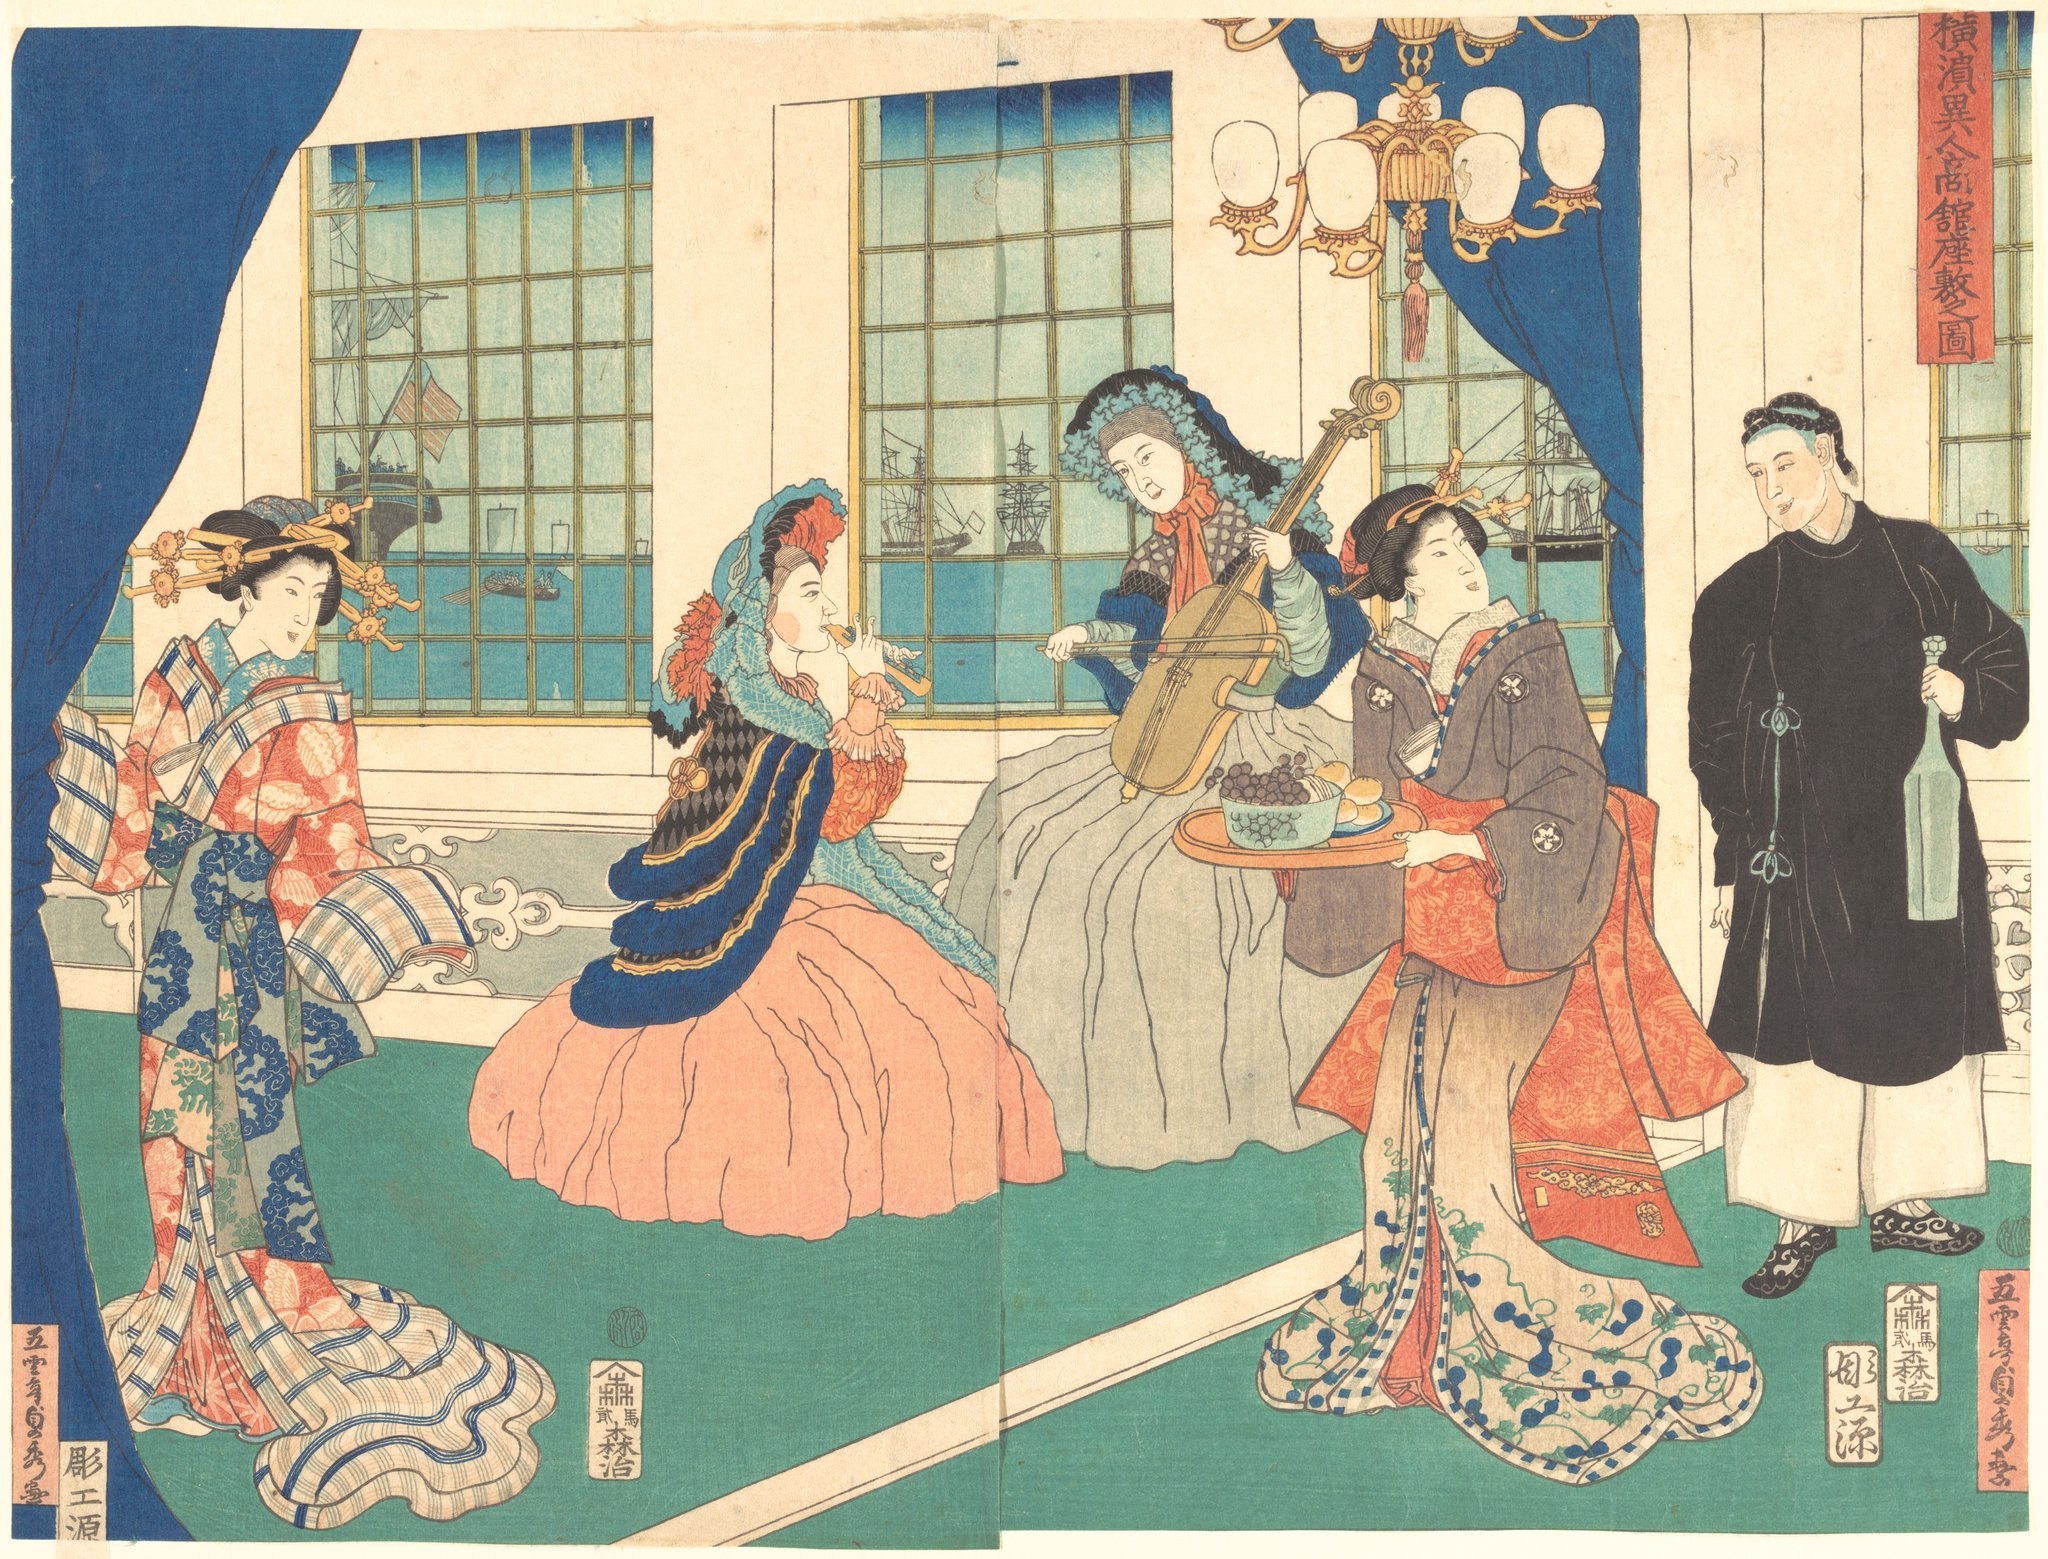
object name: print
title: Drawing Room of a Foreign Business Establishment in Yokohama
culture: japanese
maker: utagawa (gountei) sadahide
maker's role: artist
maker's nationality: japanese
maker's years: 1807-1873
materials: ink, paper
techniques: woodblock print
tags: food,musical instruments,men,women,servants